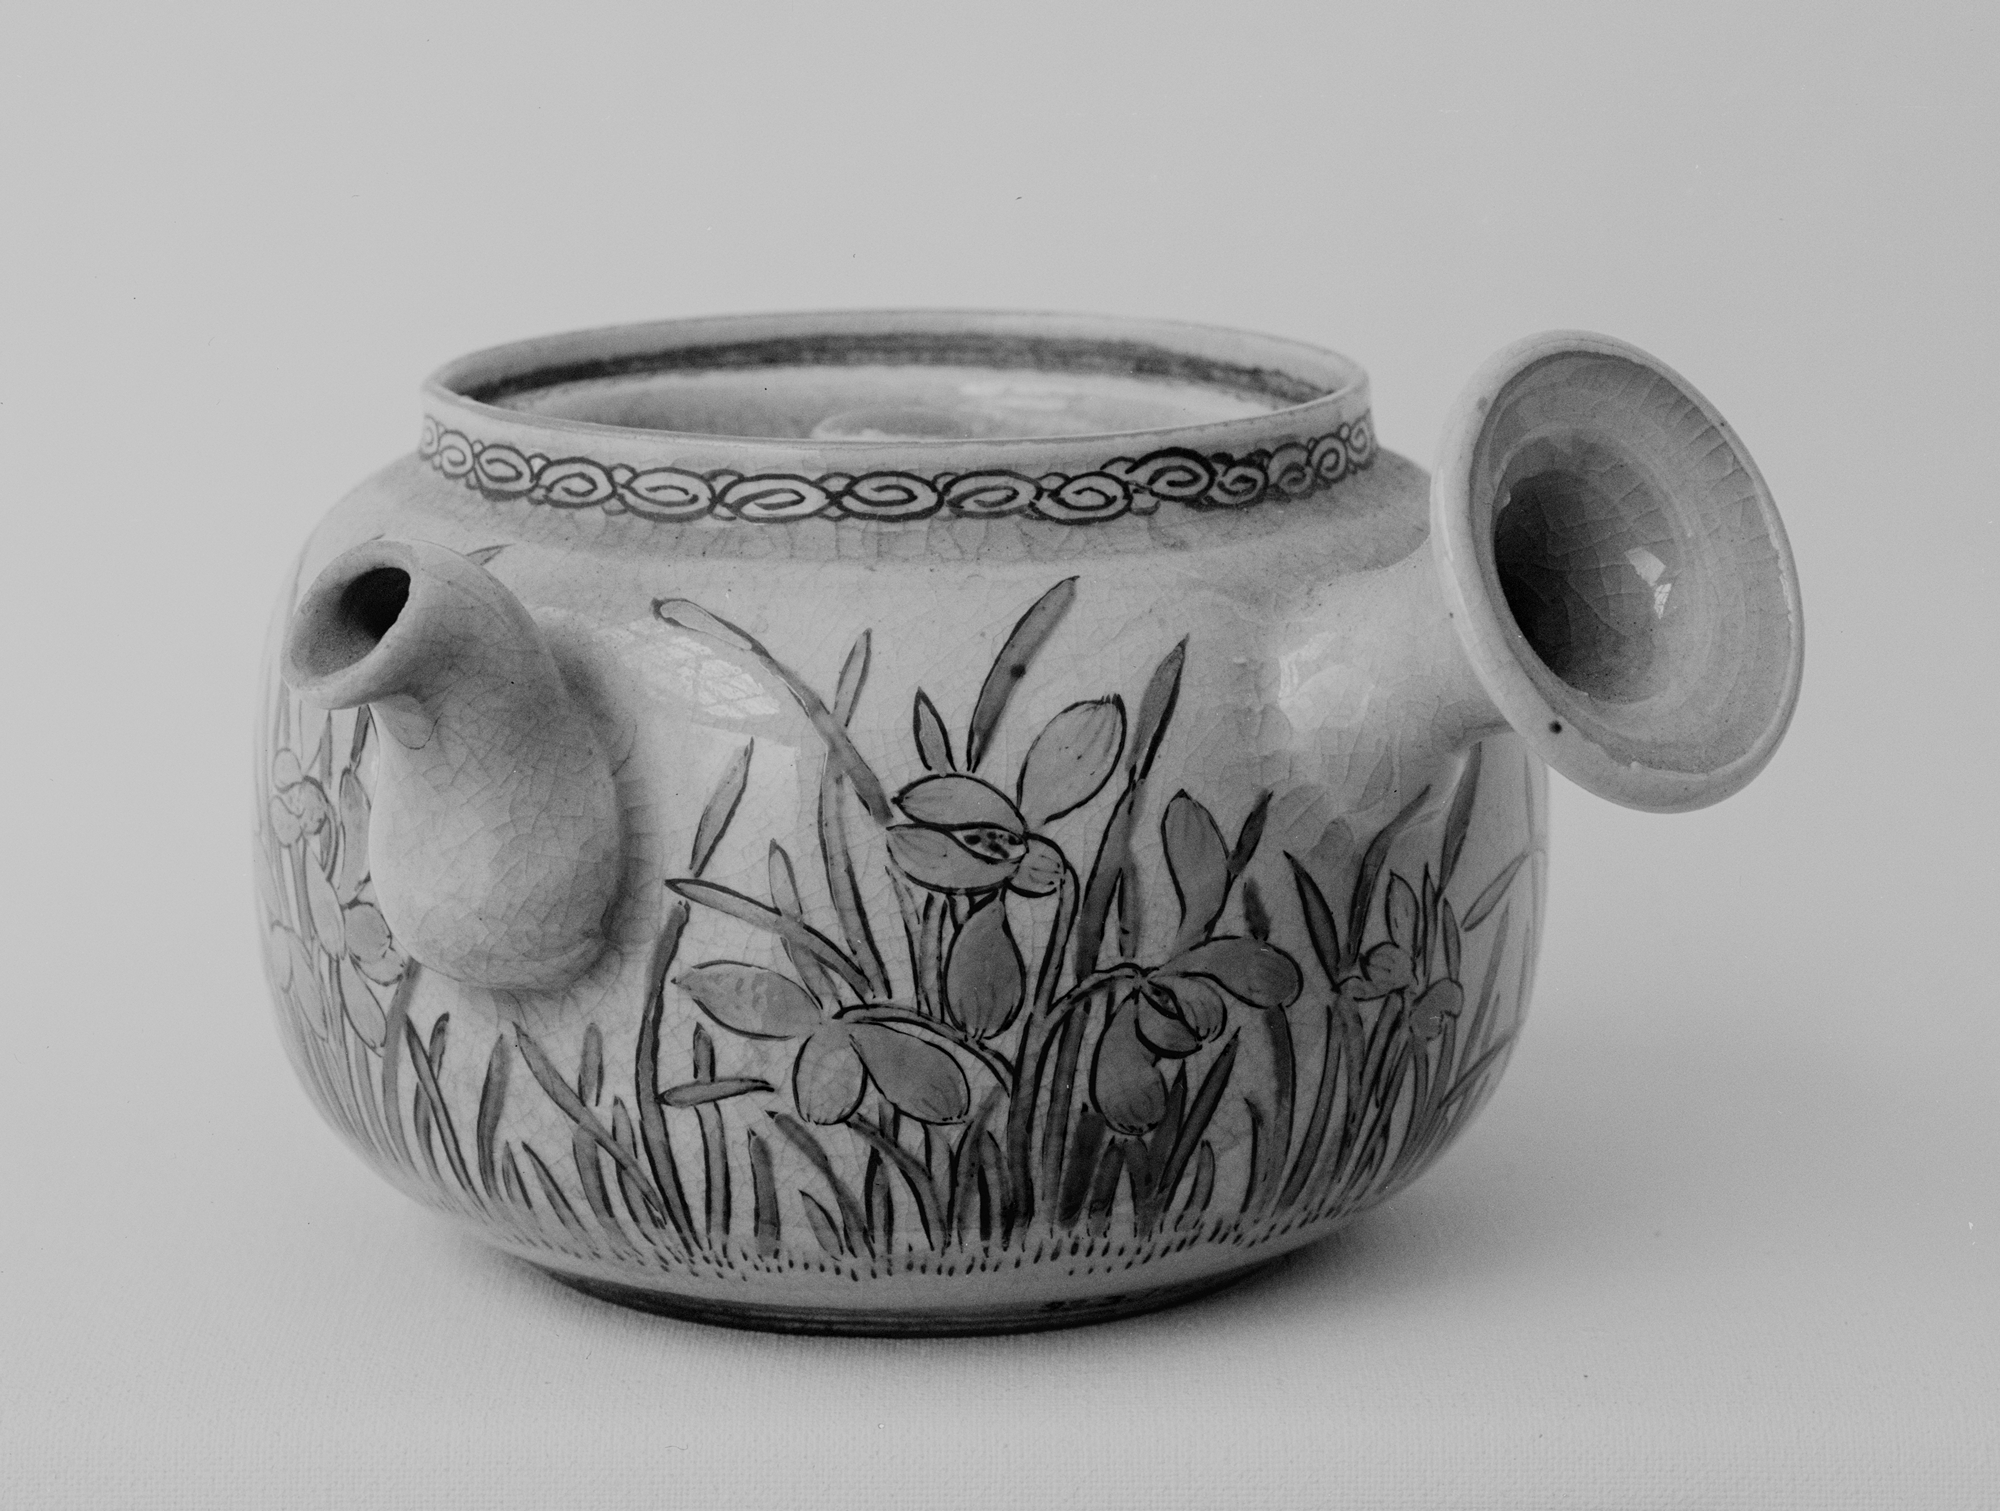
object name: teapot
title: Teapot (Kyūsu)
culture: japanese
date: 1834-1866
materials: enamel, stoneware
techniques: overglaze, polychrome